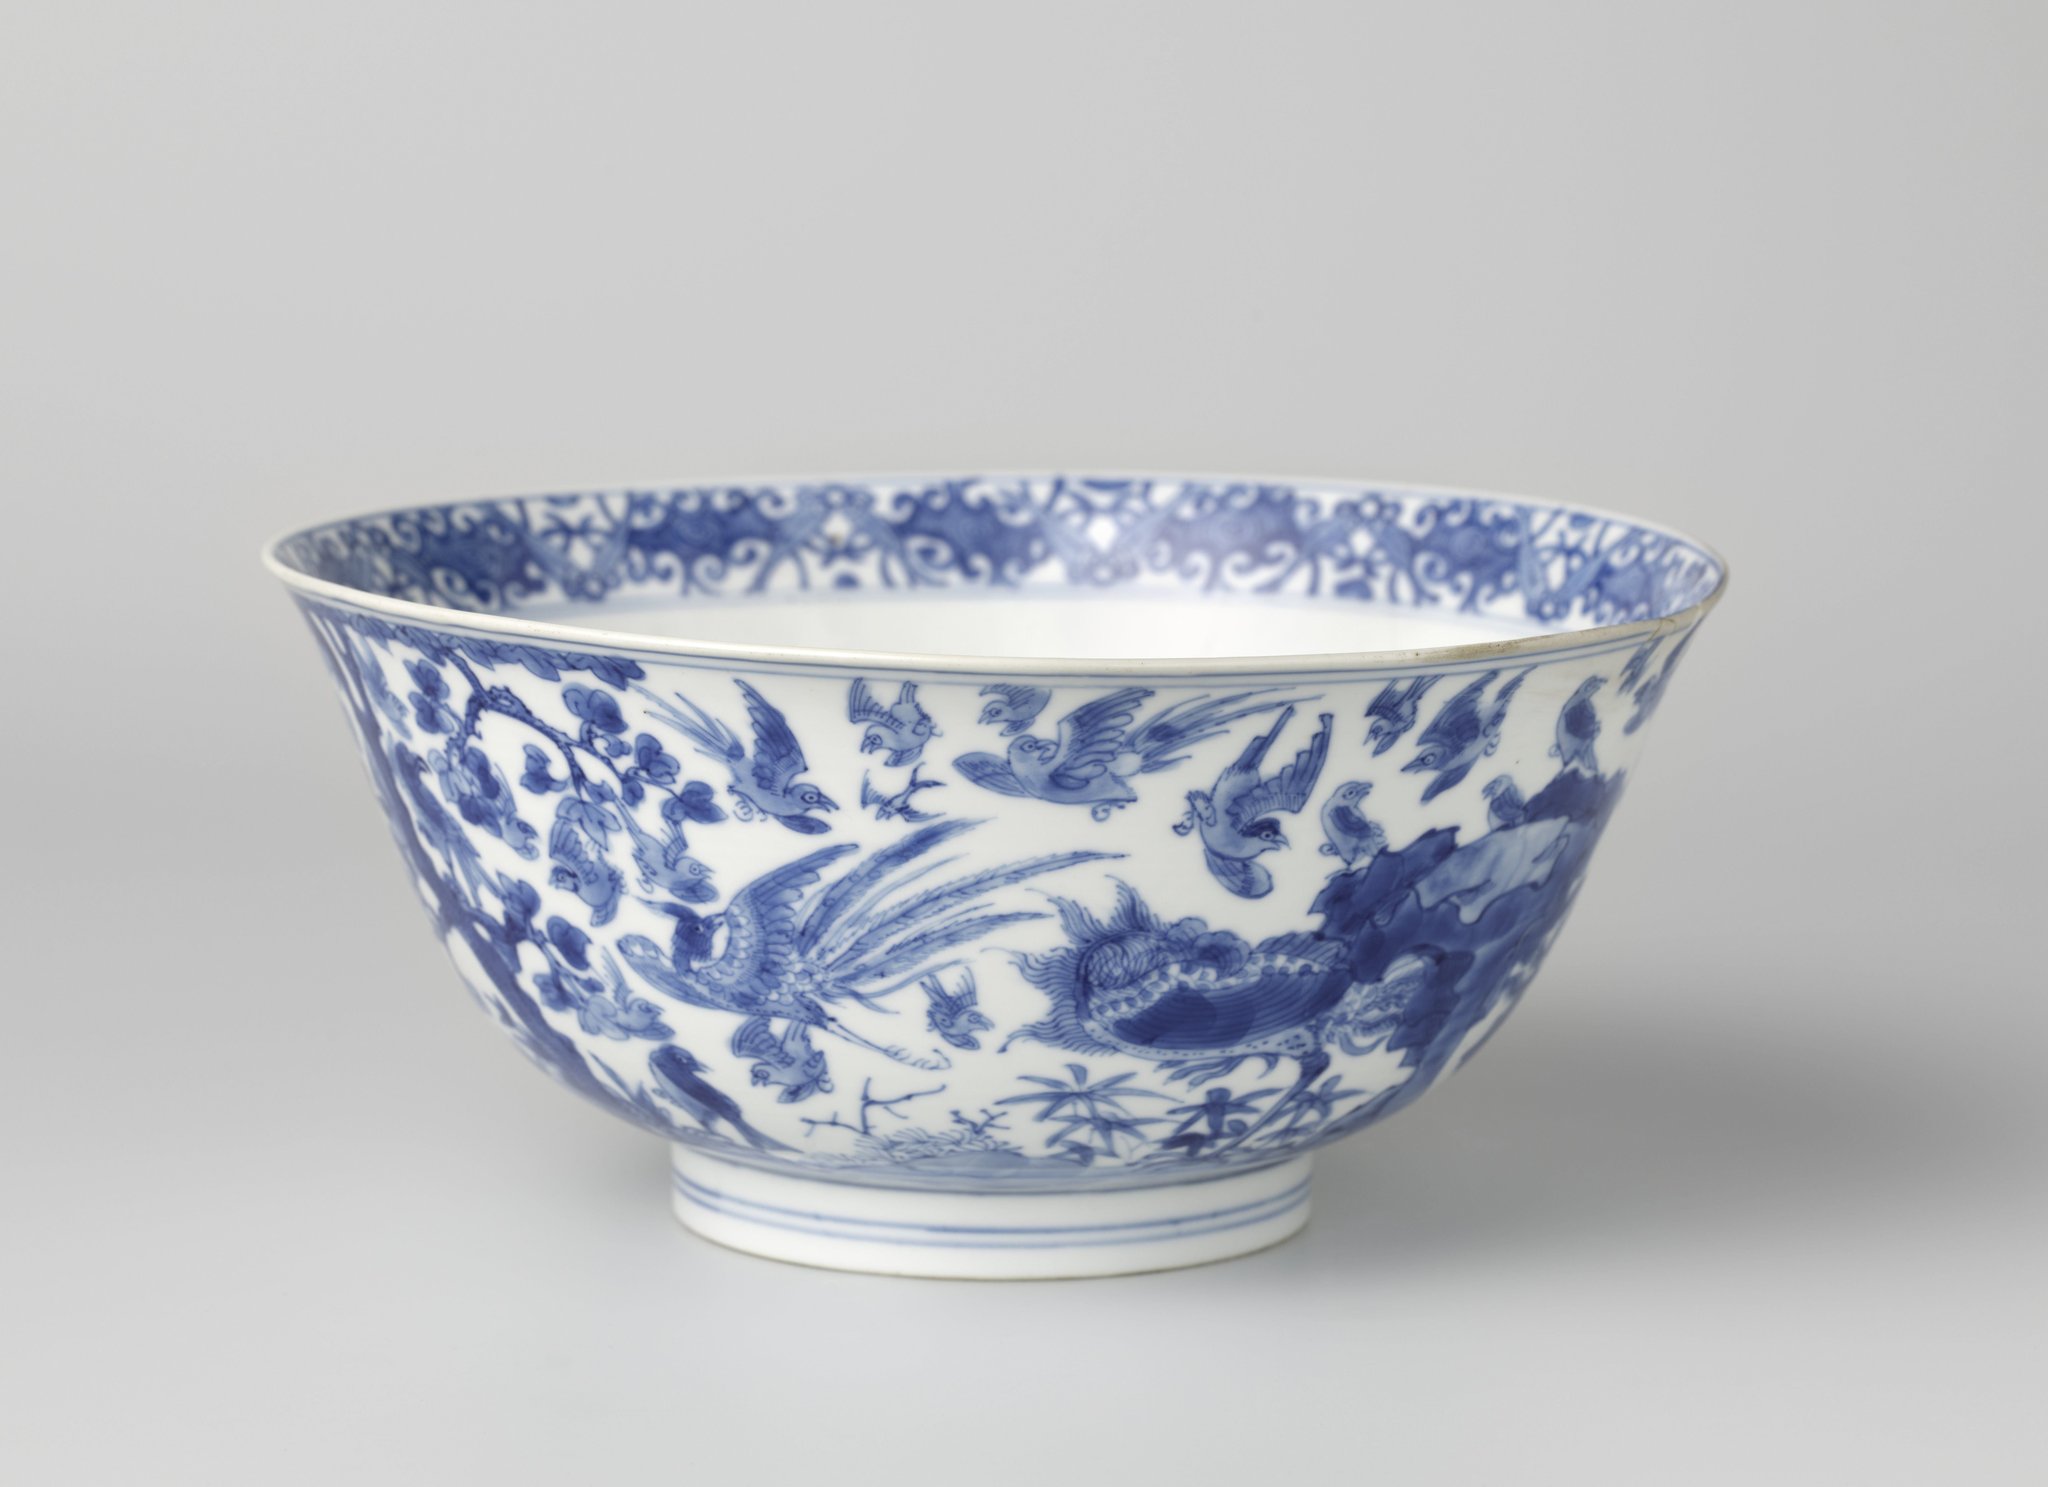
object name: bowl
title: Slop bowl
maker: Anonymous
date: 1700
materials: cobalt, glaze, paint, porcelain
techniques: firing, turning, vitrification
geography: china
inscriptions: mark: ‘大 明 成 化 年 製 dà míng Chénghuà nián zhì’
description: When taking tea, frequently different types of tea were tasted. To do so, the teacups were rinsed out in slop bowls. This one is an example of the finest blue-and-white porcelain for sale in the northern Netherlands around 1700. Such a bowl could also be part of a group of decorative porcelain objects displayed on a cabinet.